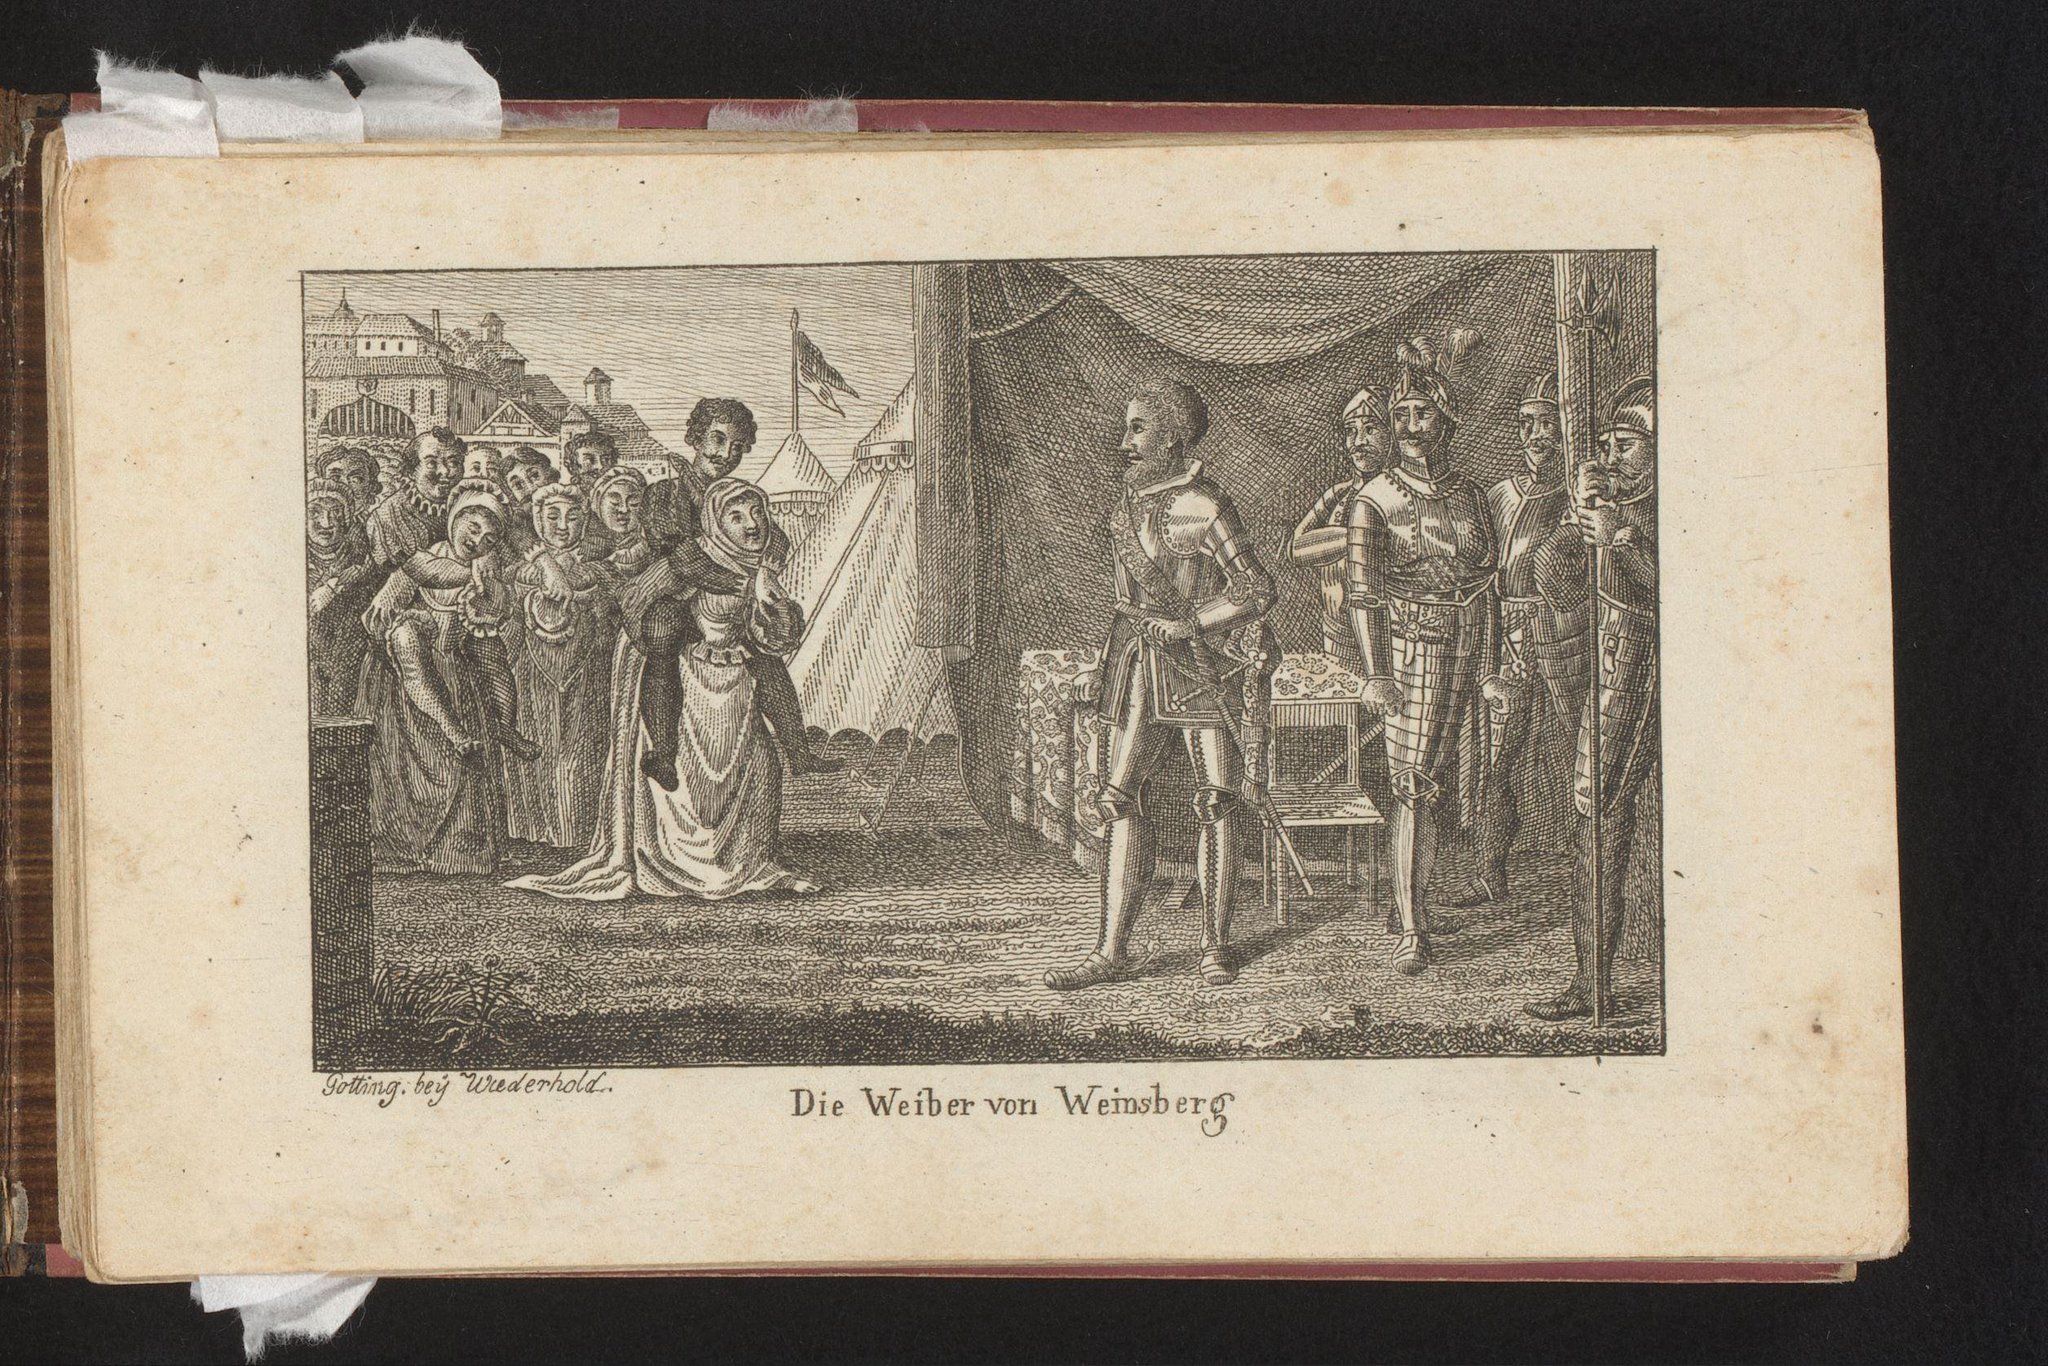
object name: print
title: Vrouwen van Weinsberg met hun mannen op de rug bij koning Konrad III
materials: ink, paper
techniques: etching, writing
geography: gottingen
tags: 'album amicorum', 'stammbuch', ingenuity; 'ingegno' (ripa)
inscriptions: tekst, verso, handgeschreven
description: Handgeschreven tekst in het Duits op het verso.